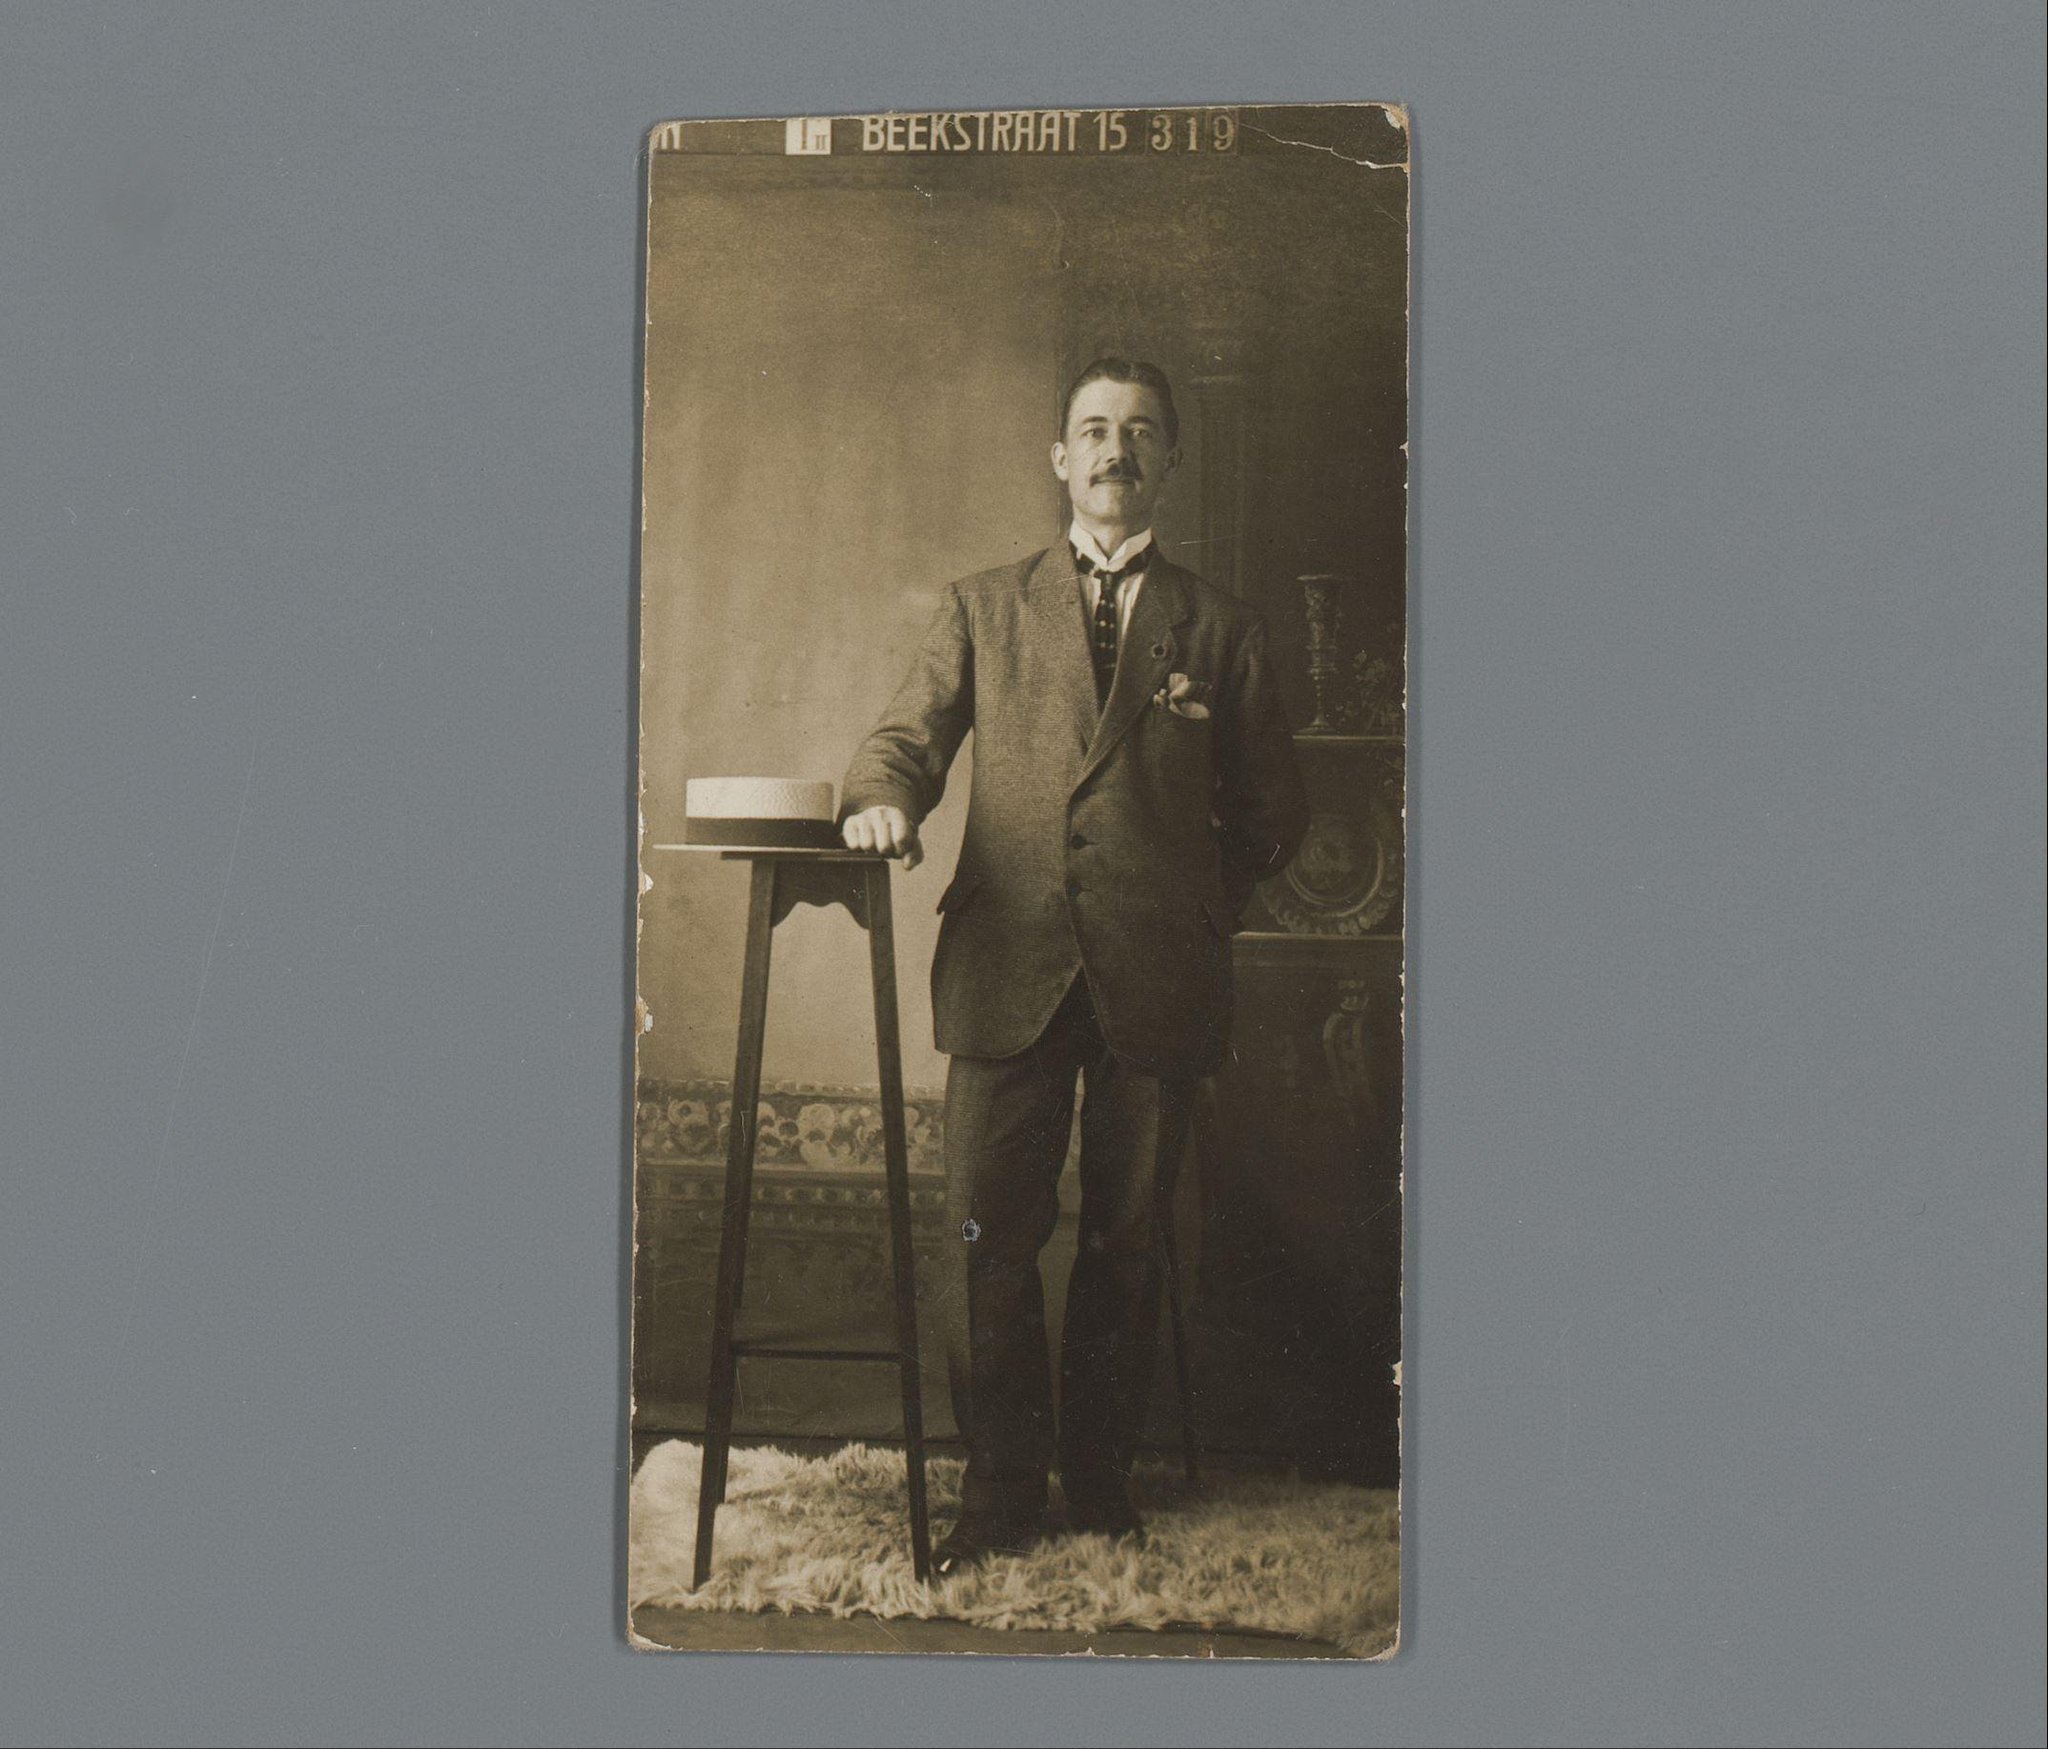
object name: snapshot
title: Portret van een onbekende man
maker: fedde woudstra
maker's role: fotograaf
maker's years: 1893-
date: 1915-1923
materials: paper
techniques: gelatin silver print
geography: arnhem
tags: adult man, anonymous historical person portrayed, arnhem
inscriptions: address: ‘BEEKSTRAAT 15’